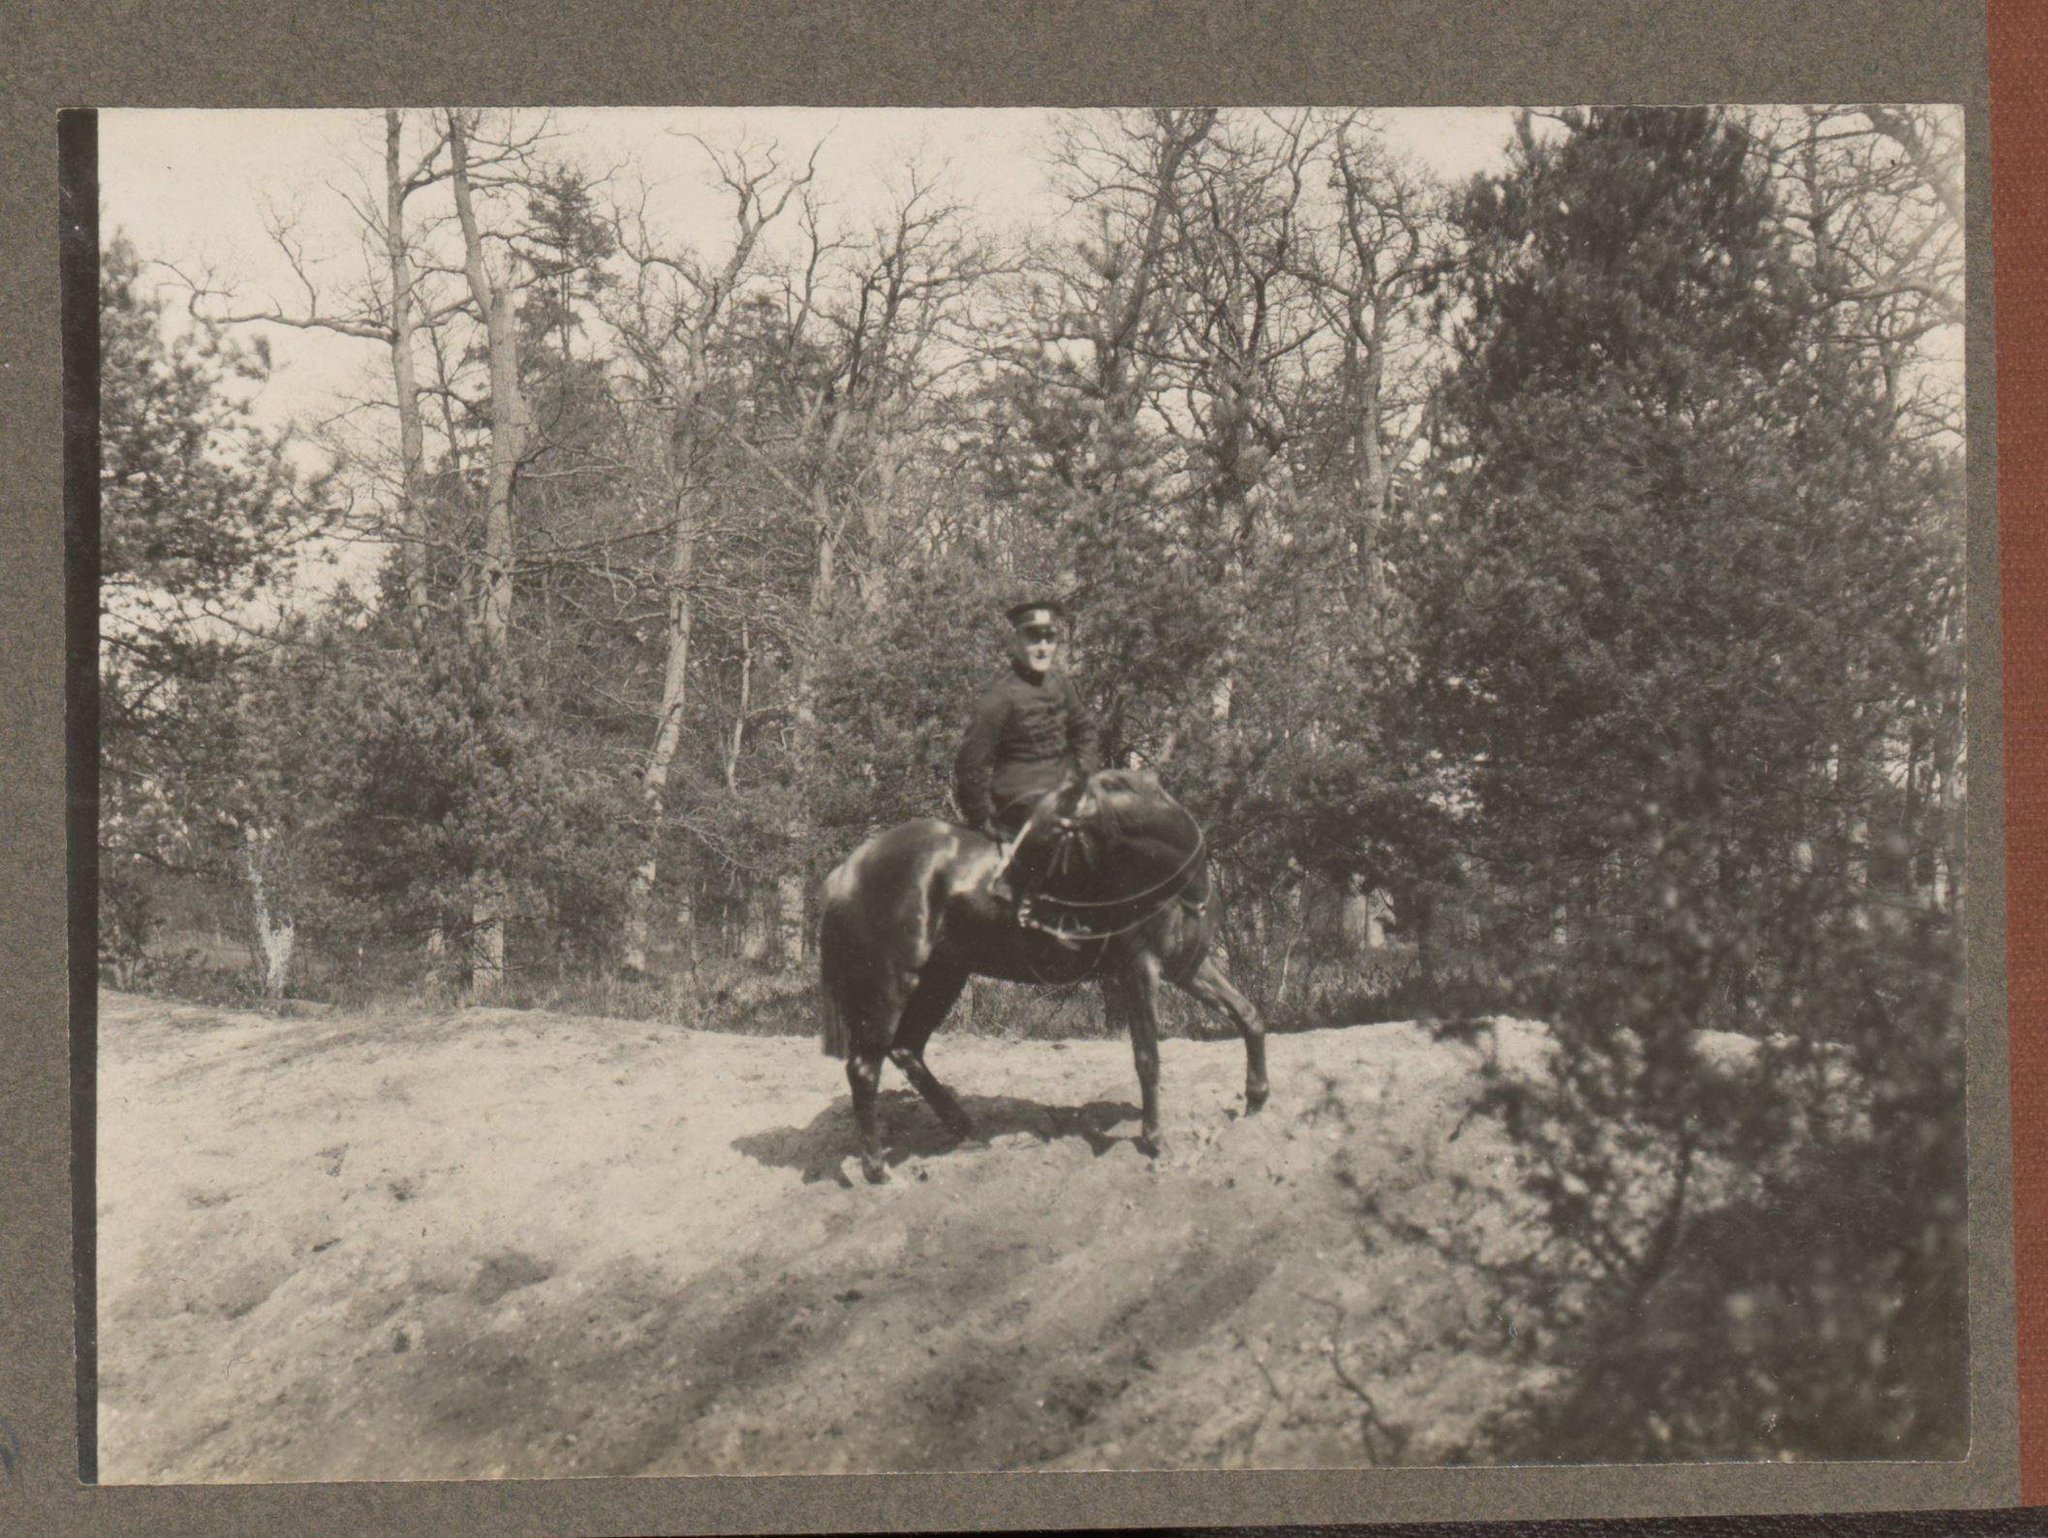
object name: photograph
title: Ruitertafereel op Koninklijke Houtvesterij Het Loo: ruiter op een zandwal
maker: Anonymous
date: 1900-1925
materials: photographic support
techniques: gelatin silver print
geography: het loo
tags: riding a horse, ass, or mule; rider, horseman, hunting, chase, hunting-ground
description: Onderdeel van Fotoalbum van de heer Brams, opperhoutvester van koningin Wilhelmina op Koninklijke Houtvesterij Het Loo.